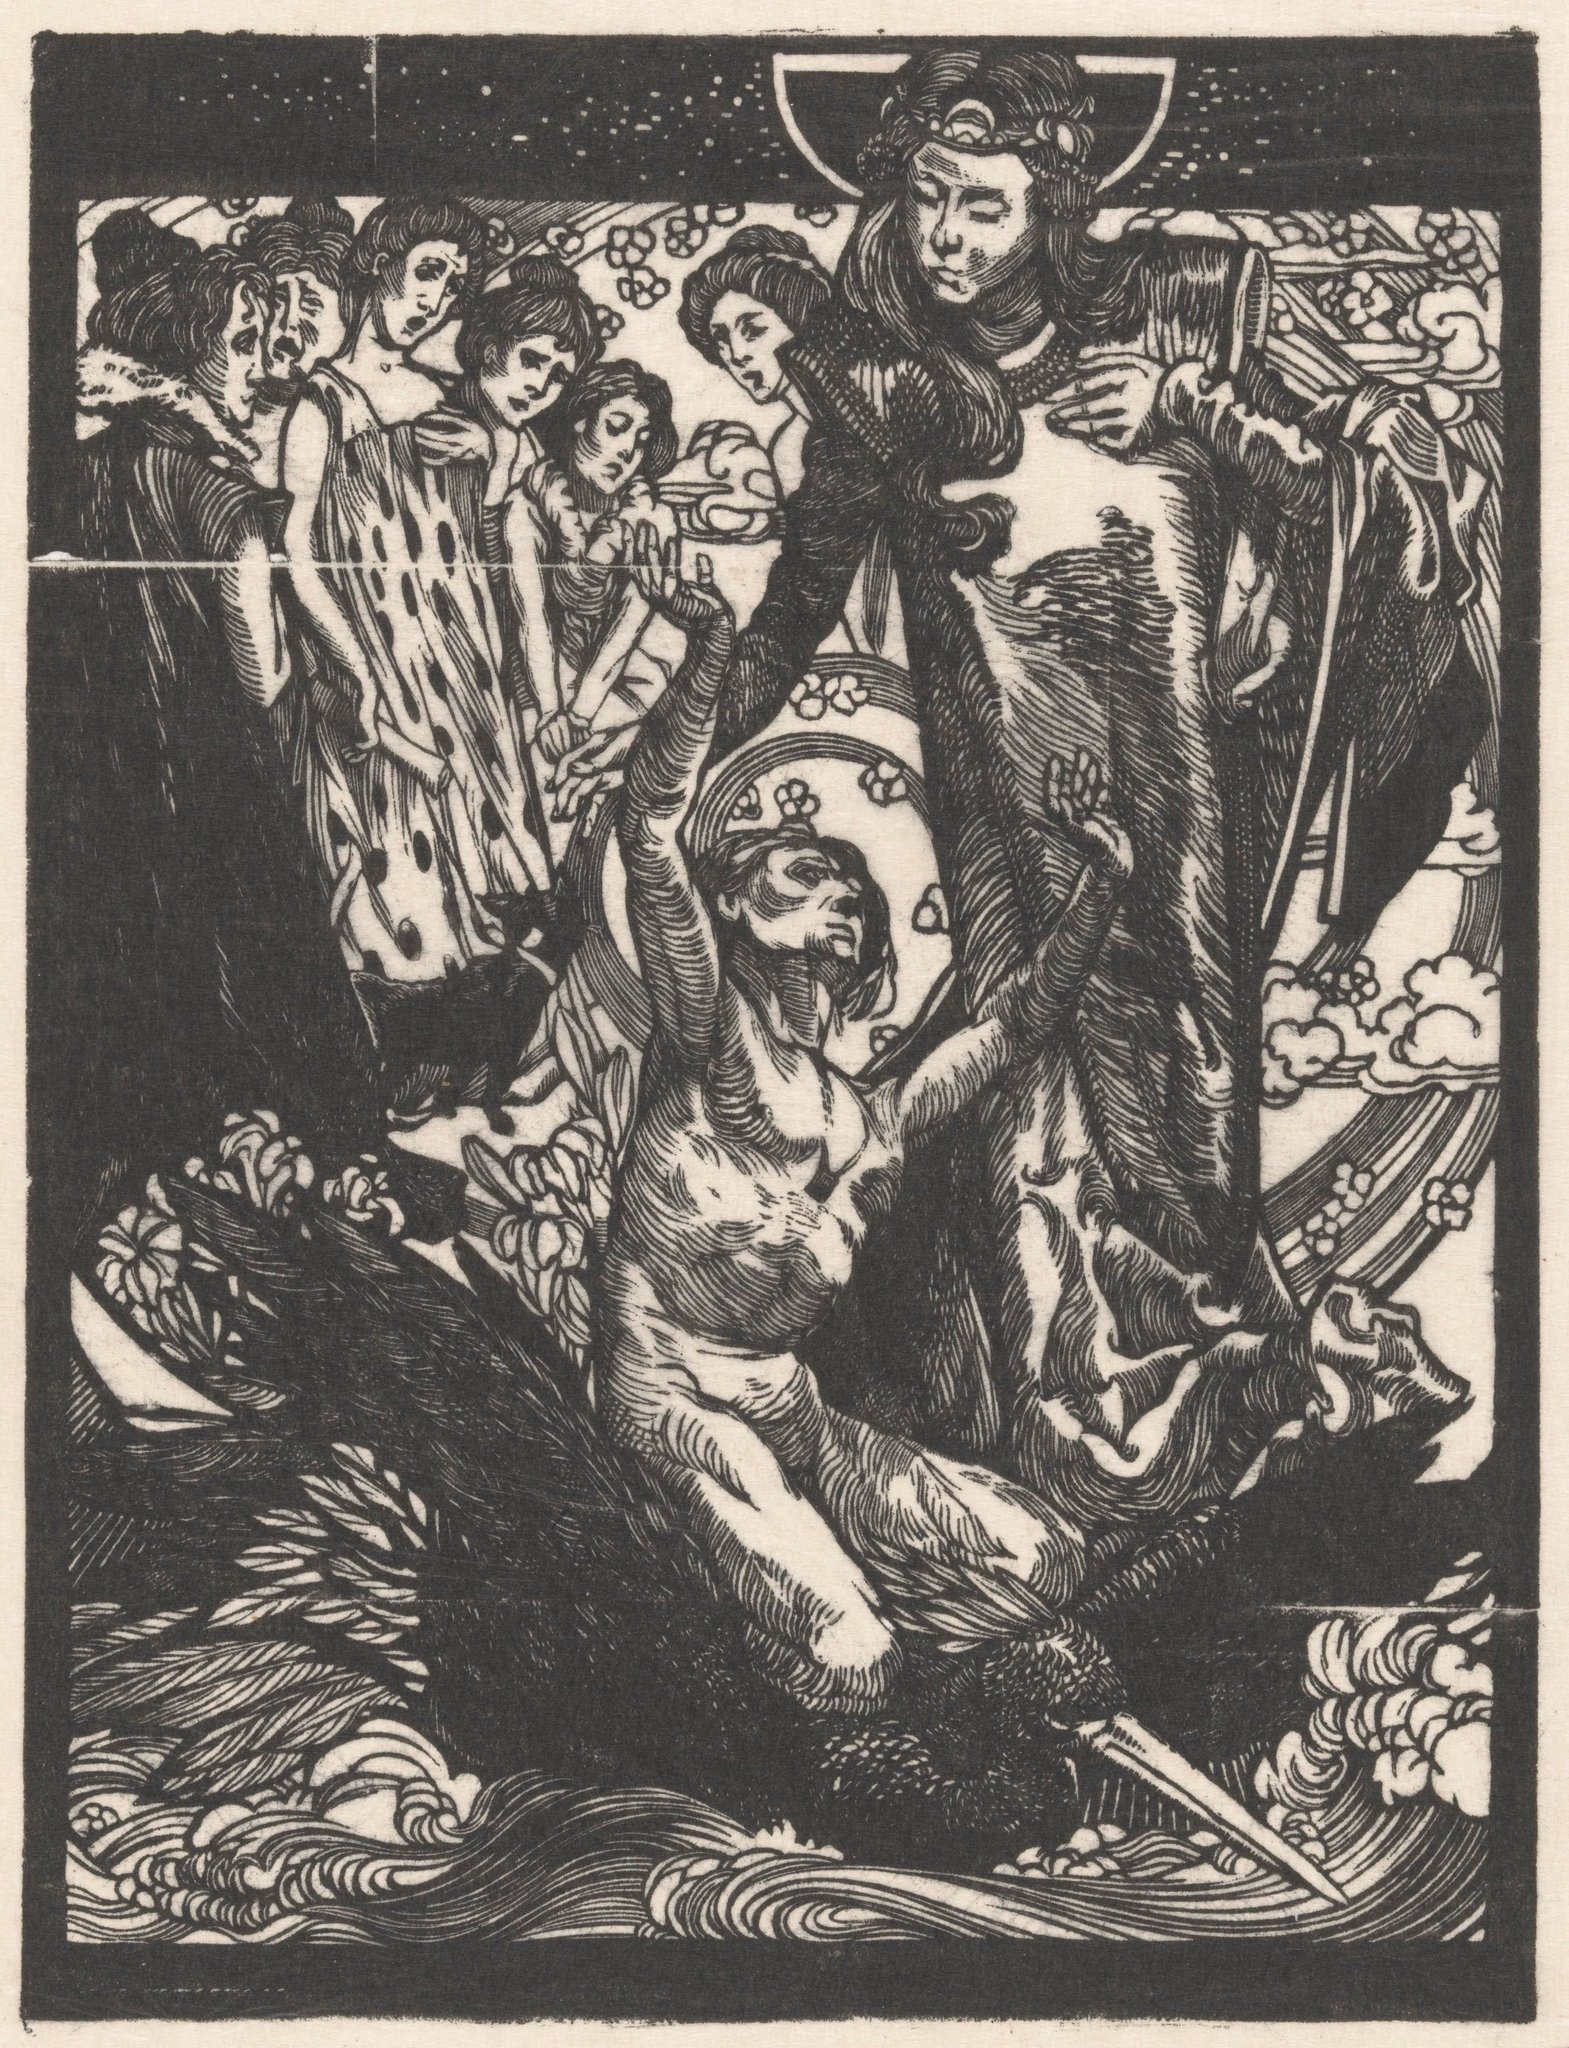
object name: print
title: Vrouwenfiguren met man op rug van vogel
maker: johannes josephus aarts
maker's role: draughtsman, print maker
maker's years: 1871-1934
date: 1881-1934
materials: paper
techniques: woodcut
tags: flying on or with the aid of animal(s), flowers, cat, birds, surrealia, surrealistic representations, lohengrin or the knight of the swan, in german legend the son of percival or parsifal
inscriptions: collector's mark: Lugt 2228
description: Een naakte man vliegt op de rug van een vogel. Hij heft zijn armen ten hemel. Hij wordt van boven bekeken door verschillende vrouwen gekleed in jurken. Er is een kat in hun midden. In de lucht zweven wolken en bloemen.